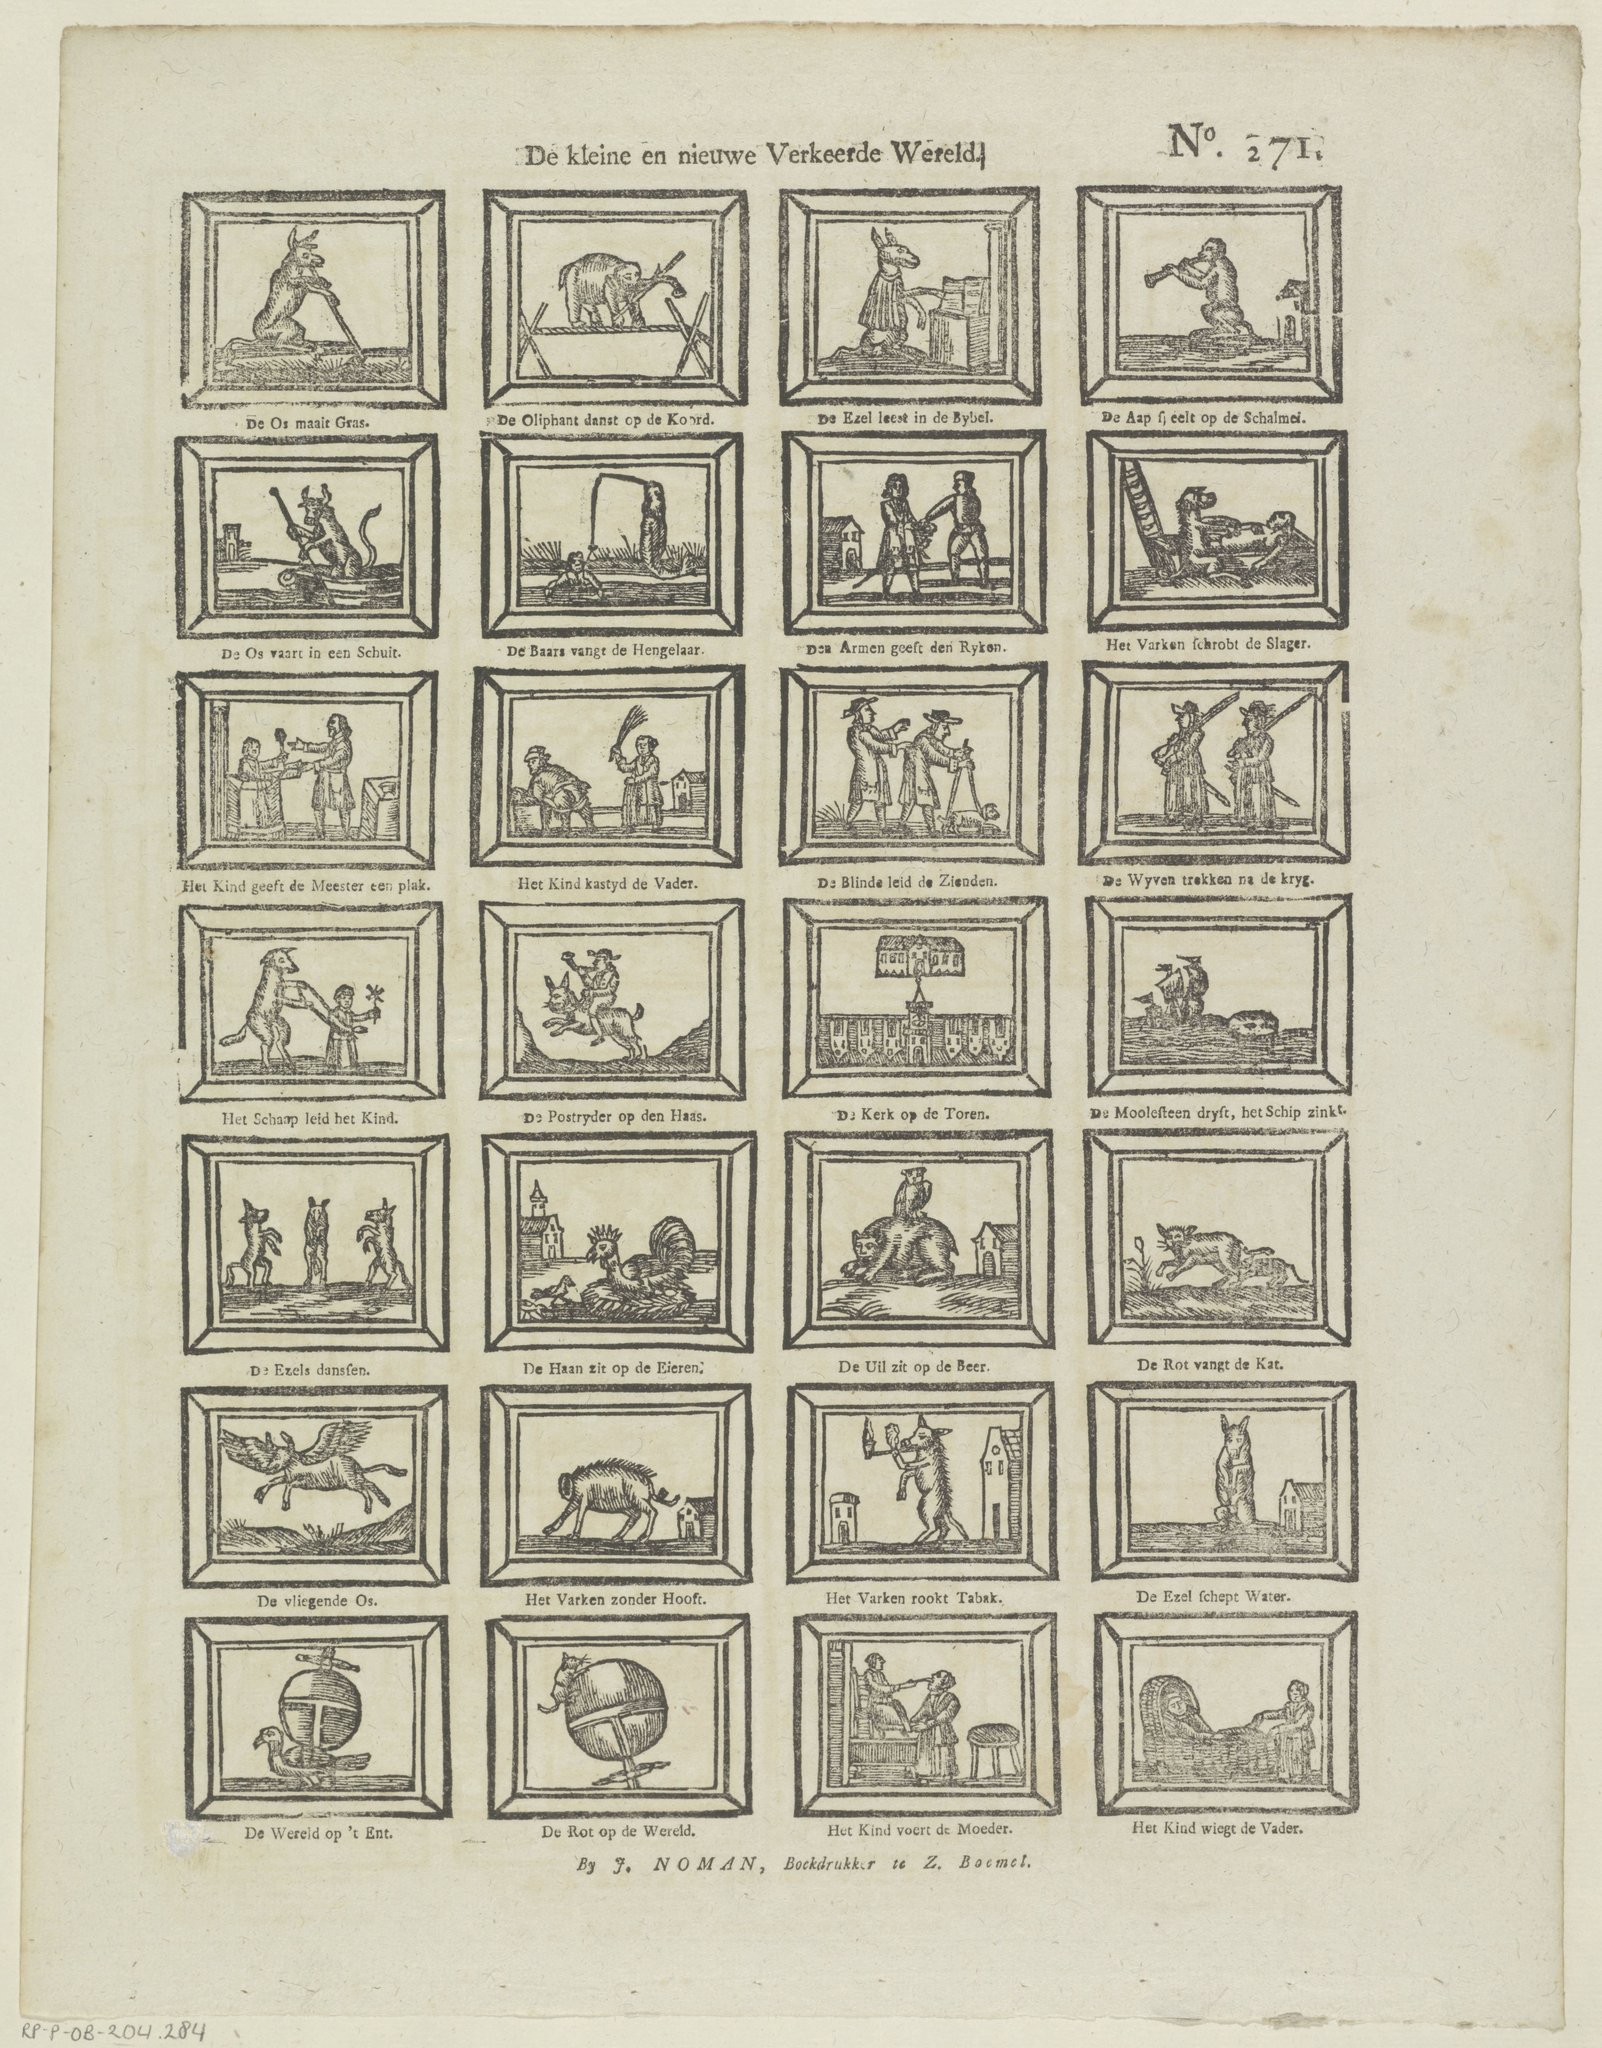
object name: print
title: De kleine en nieuwe Verkeerde Wereld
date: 1806-1830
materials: paper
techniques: letterpress printing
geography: zaltbommel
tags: 'mundus inversus', the reversed world, the topsy-turvy world, 'le monde bestourné', animals acting as human beings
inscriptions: collector's mark: Lugt 2760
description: Blad met 28 voorstellingen over de verkeerde wereld, waar onder andere dieren zich als mensen gedragen. Onder elke afbeelding een onderschrift. Genummerd rechtsboven: No. 271.